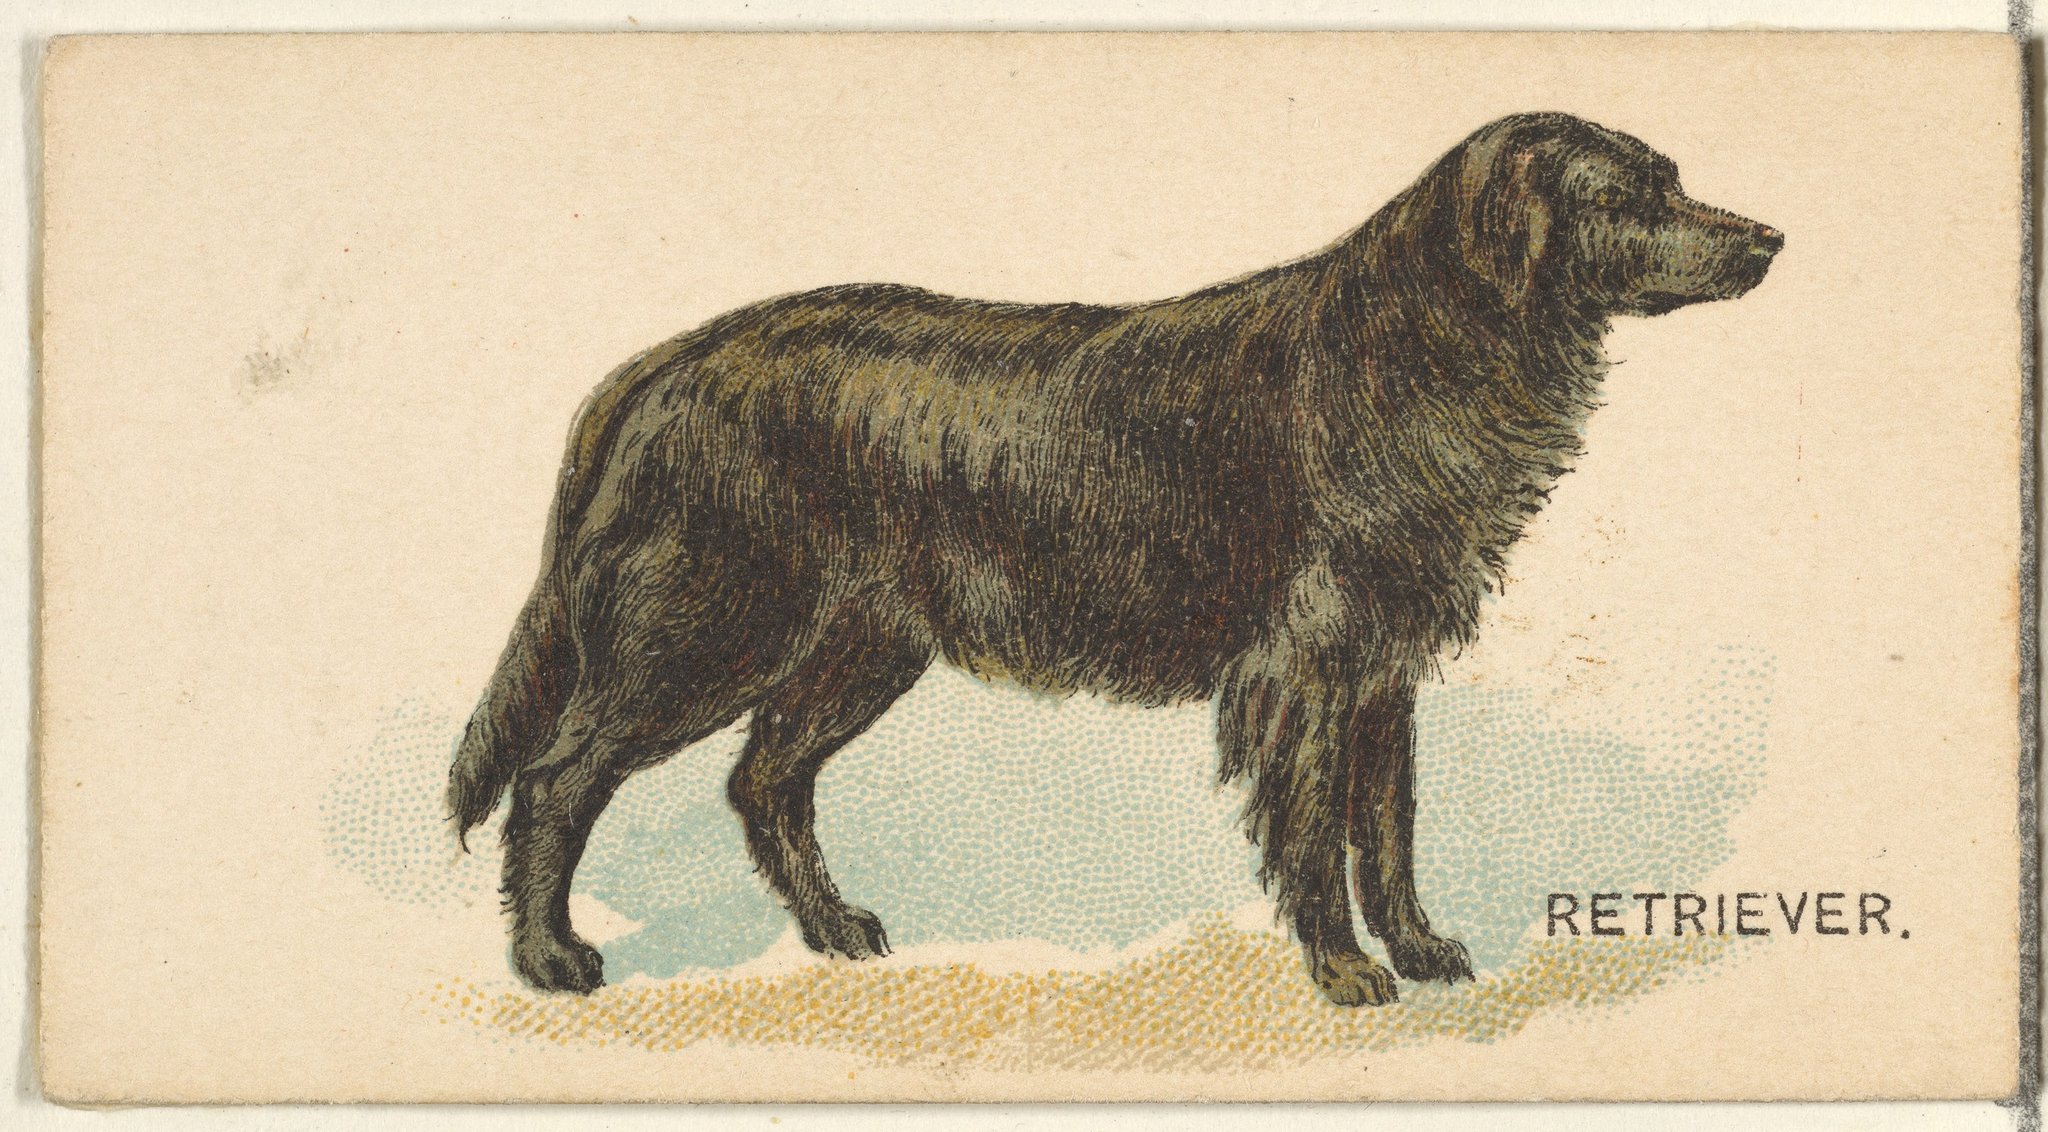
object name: print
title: Retriever, from the Dogs of the World series for Old Judge Cigarettes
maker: goodwin & company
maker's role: publisher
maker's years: 1850-1950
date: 1890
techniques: color lithograph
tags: dogs